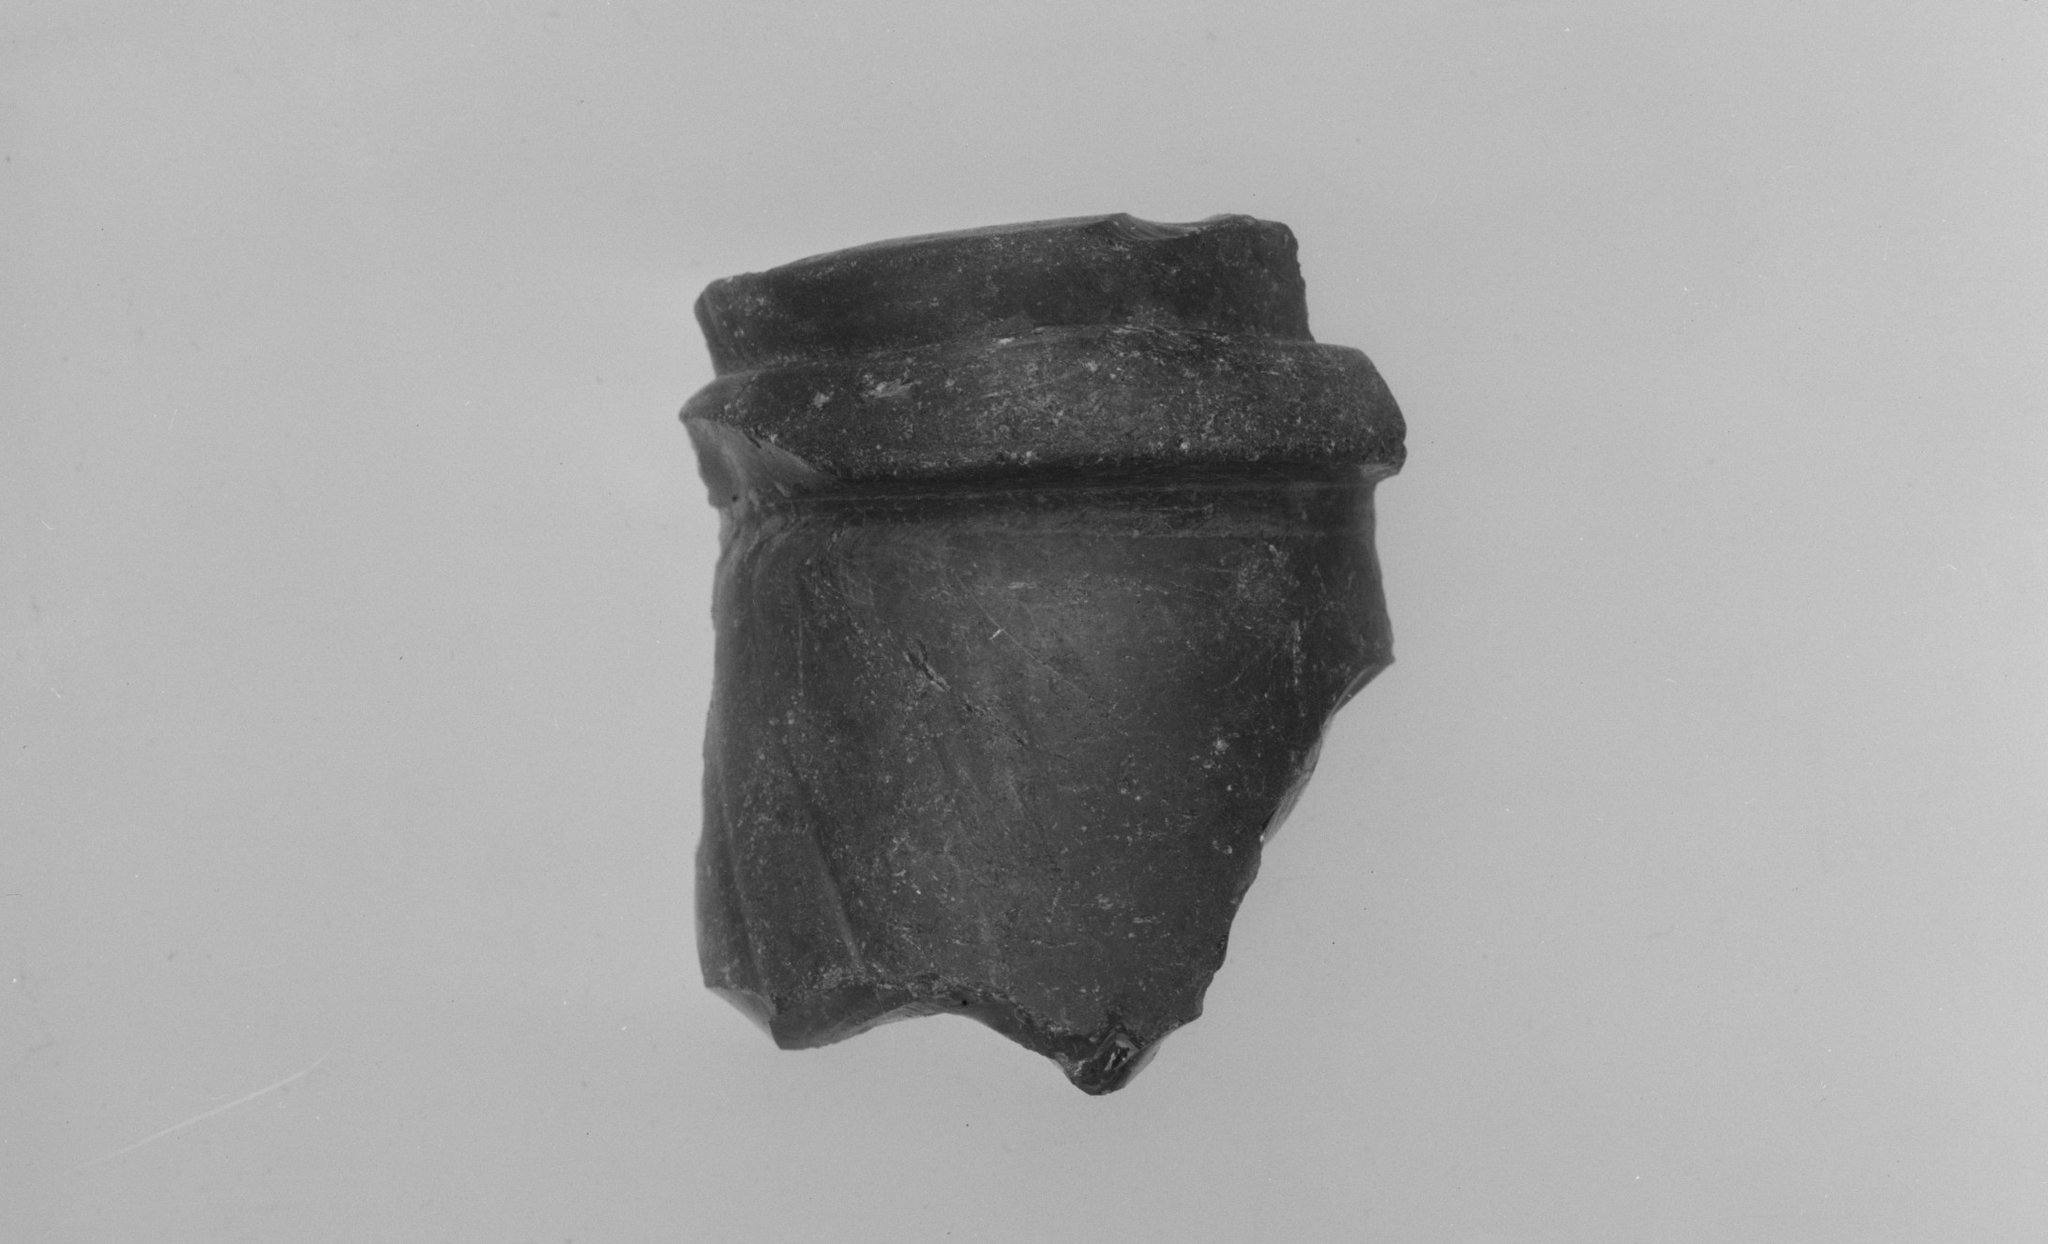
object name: bottle fragment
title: Fragment of a Bottle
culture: american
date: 1701-1800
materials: glass, lead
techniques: glassblowing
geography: united states